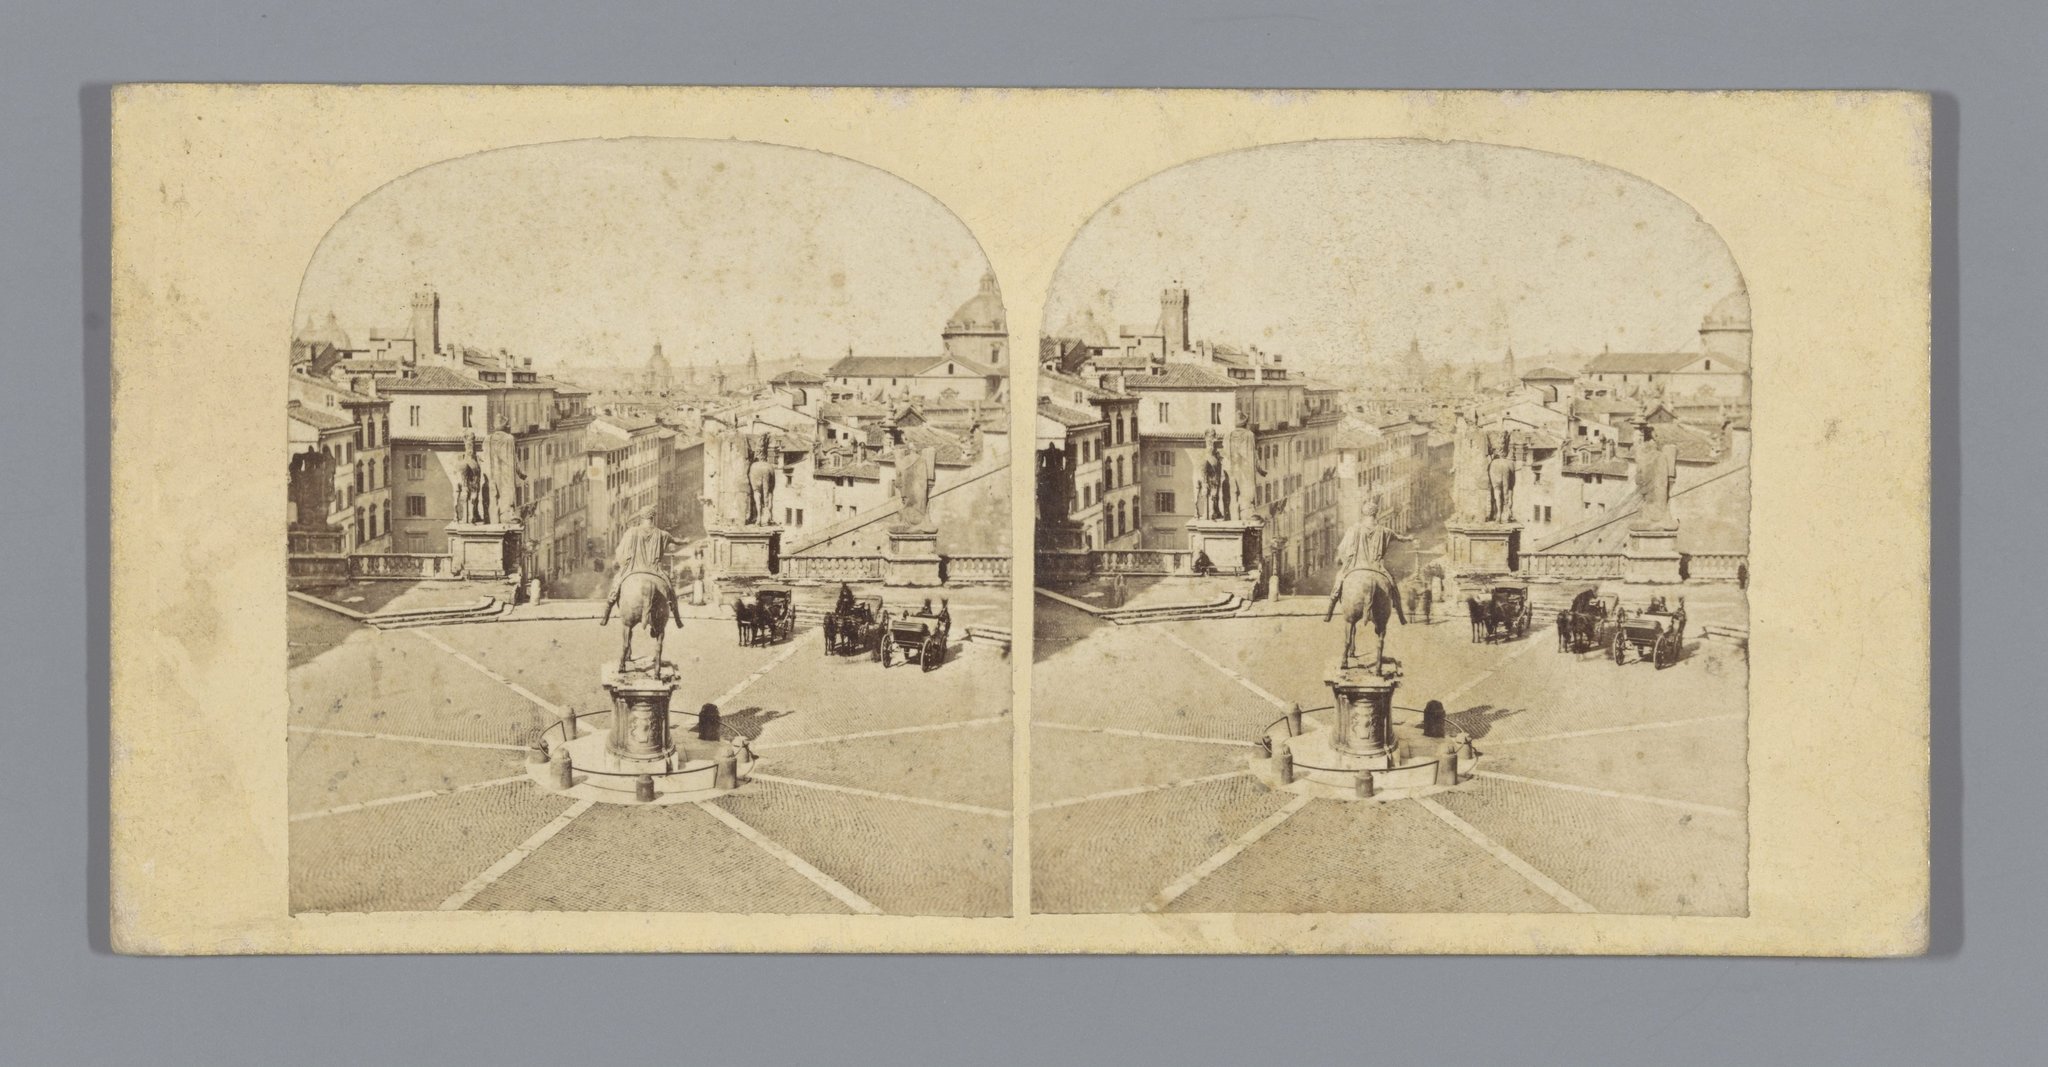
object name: stereograph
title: Gezicht op het Piazza del Campidoglio te Rome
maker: Anonymous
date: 1850-1880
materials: cardboard, photographic support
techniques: albumen print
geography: piazza del campidoglio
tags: square, place, circus, etc., city-view in general; 'veduta', equestrian statue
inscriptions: inscription: ‘place de Tibère Rome’, number: ‘No. 1863.’